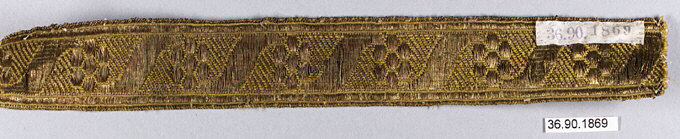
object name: galloon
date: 1767-1833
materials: silk